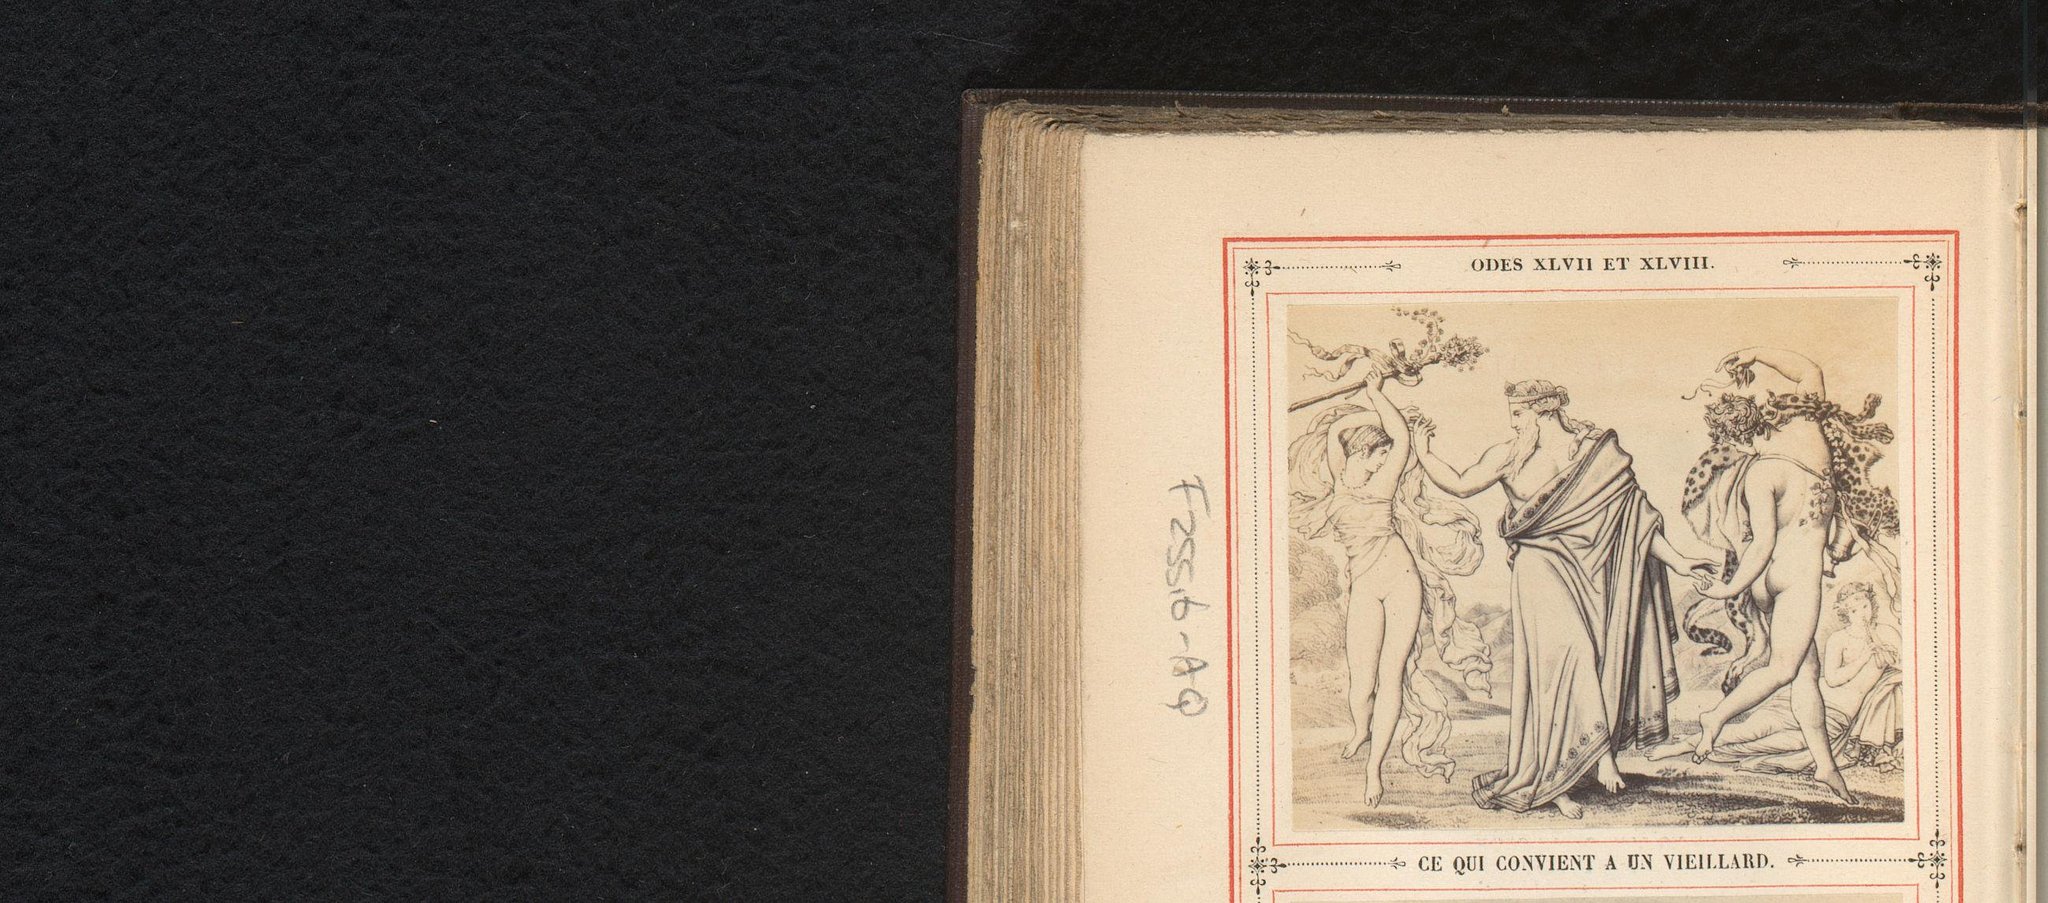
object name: reproduction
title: Fotoreproductie van een tekening van Girodet, dansende goden, illustratie bij Apothéose d'Anacréon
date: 1859-1864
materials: paper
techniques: albumen print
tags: gods ~ classical mythology